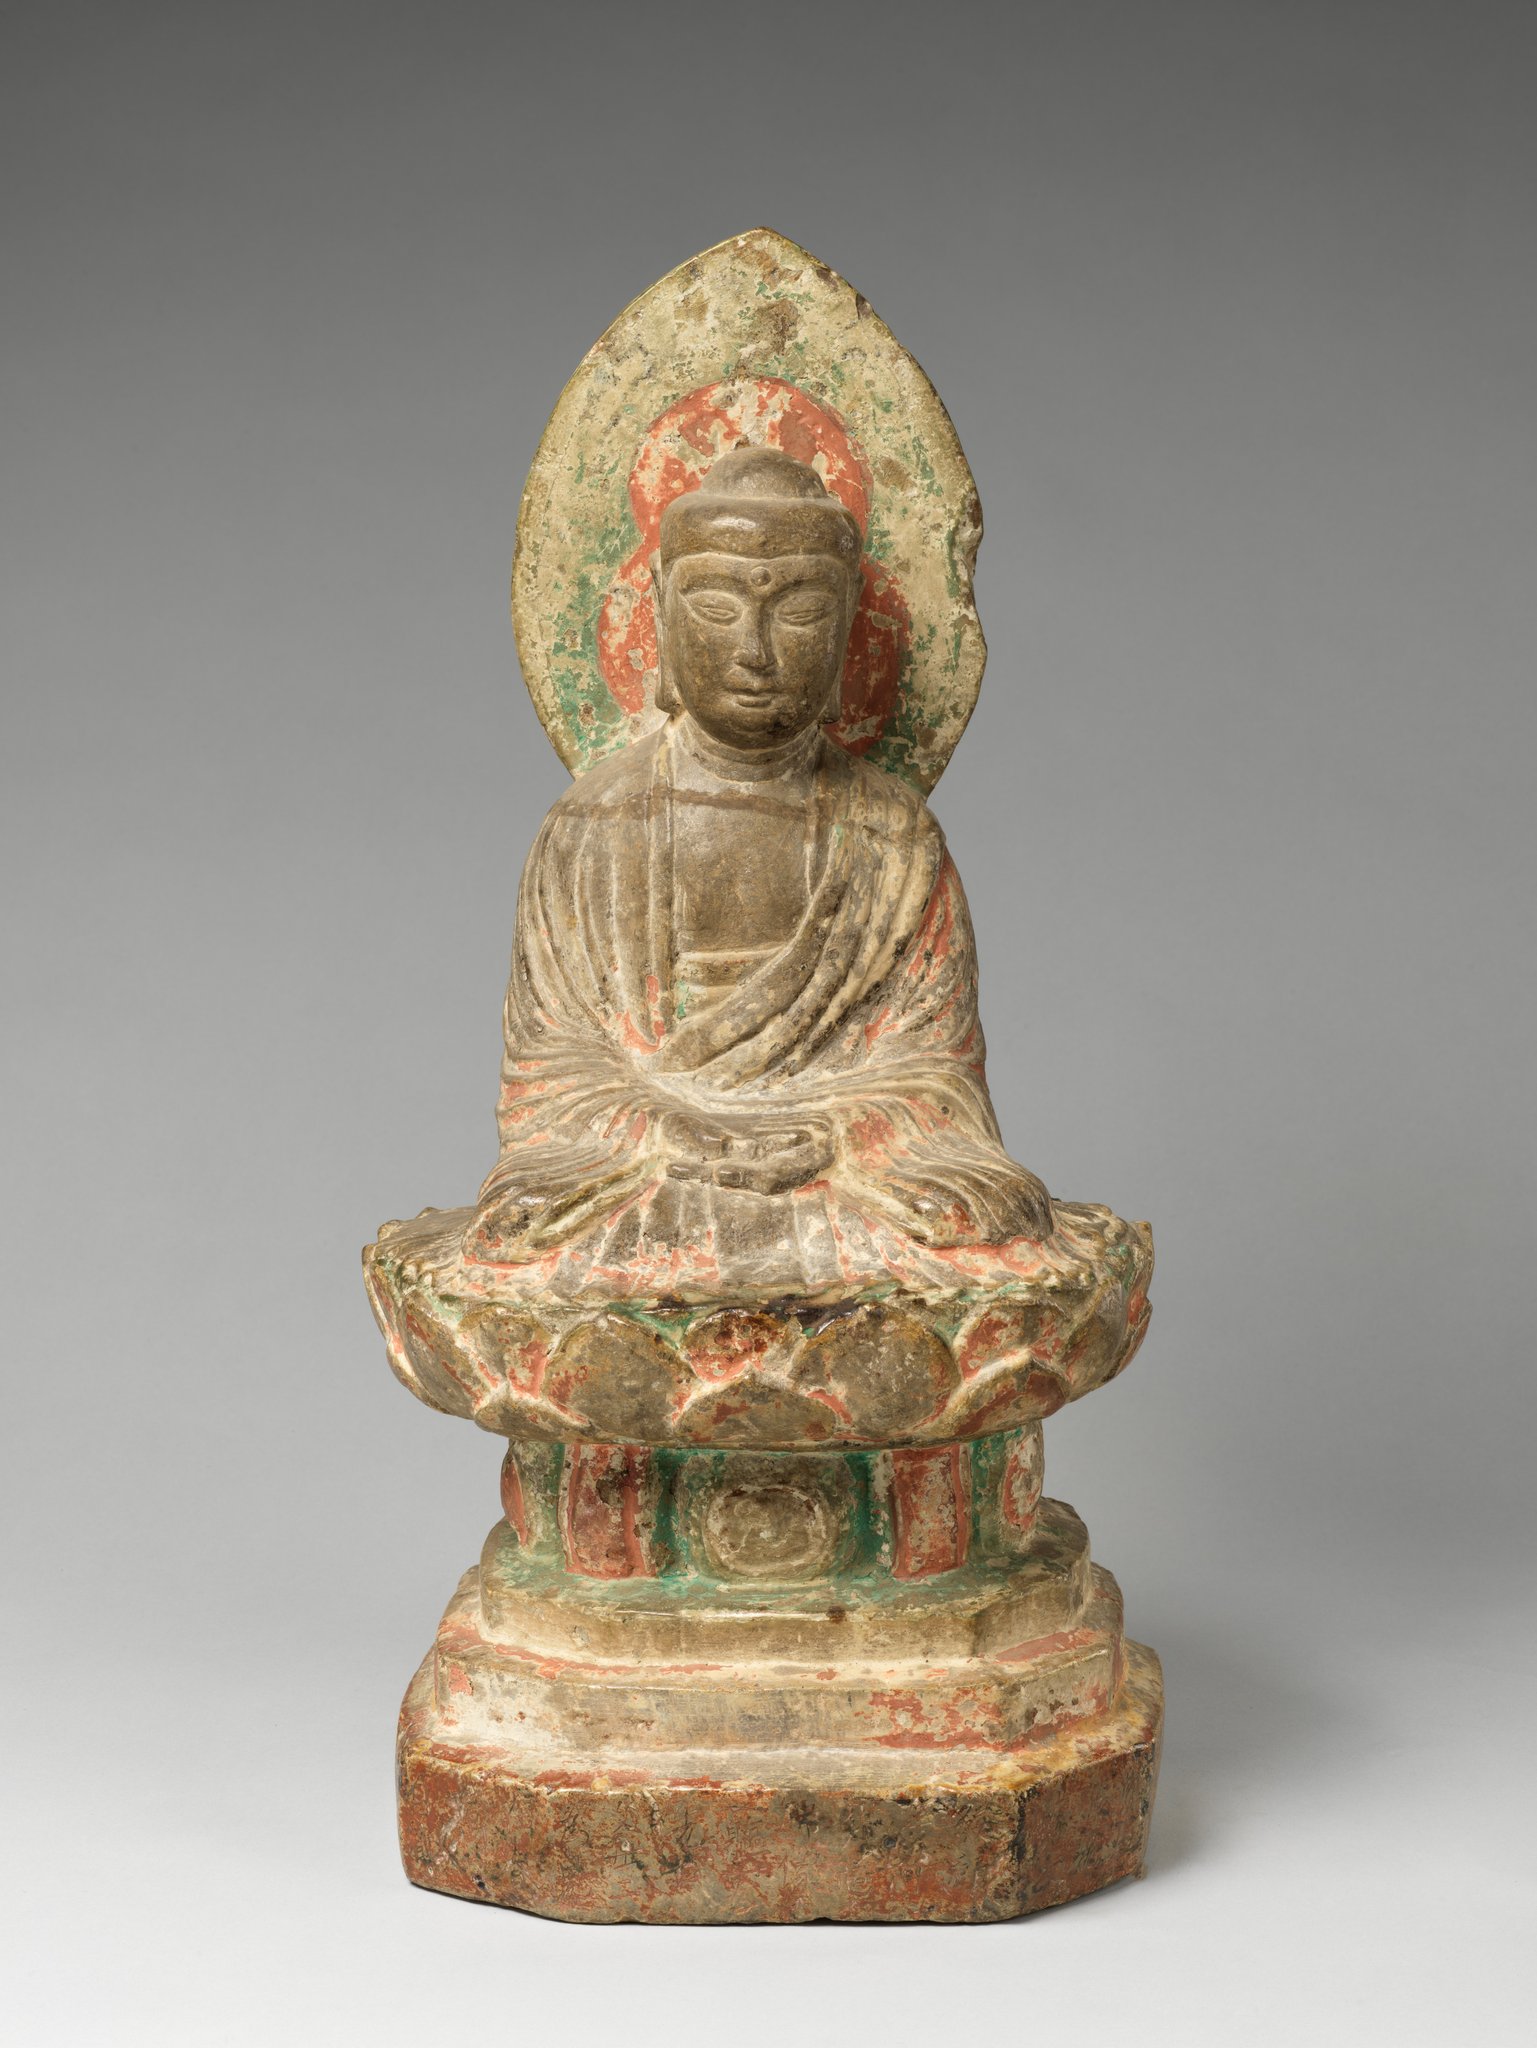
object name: figure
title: Seated Amida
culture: chinese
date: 618-907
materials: marble, paint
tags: buddha